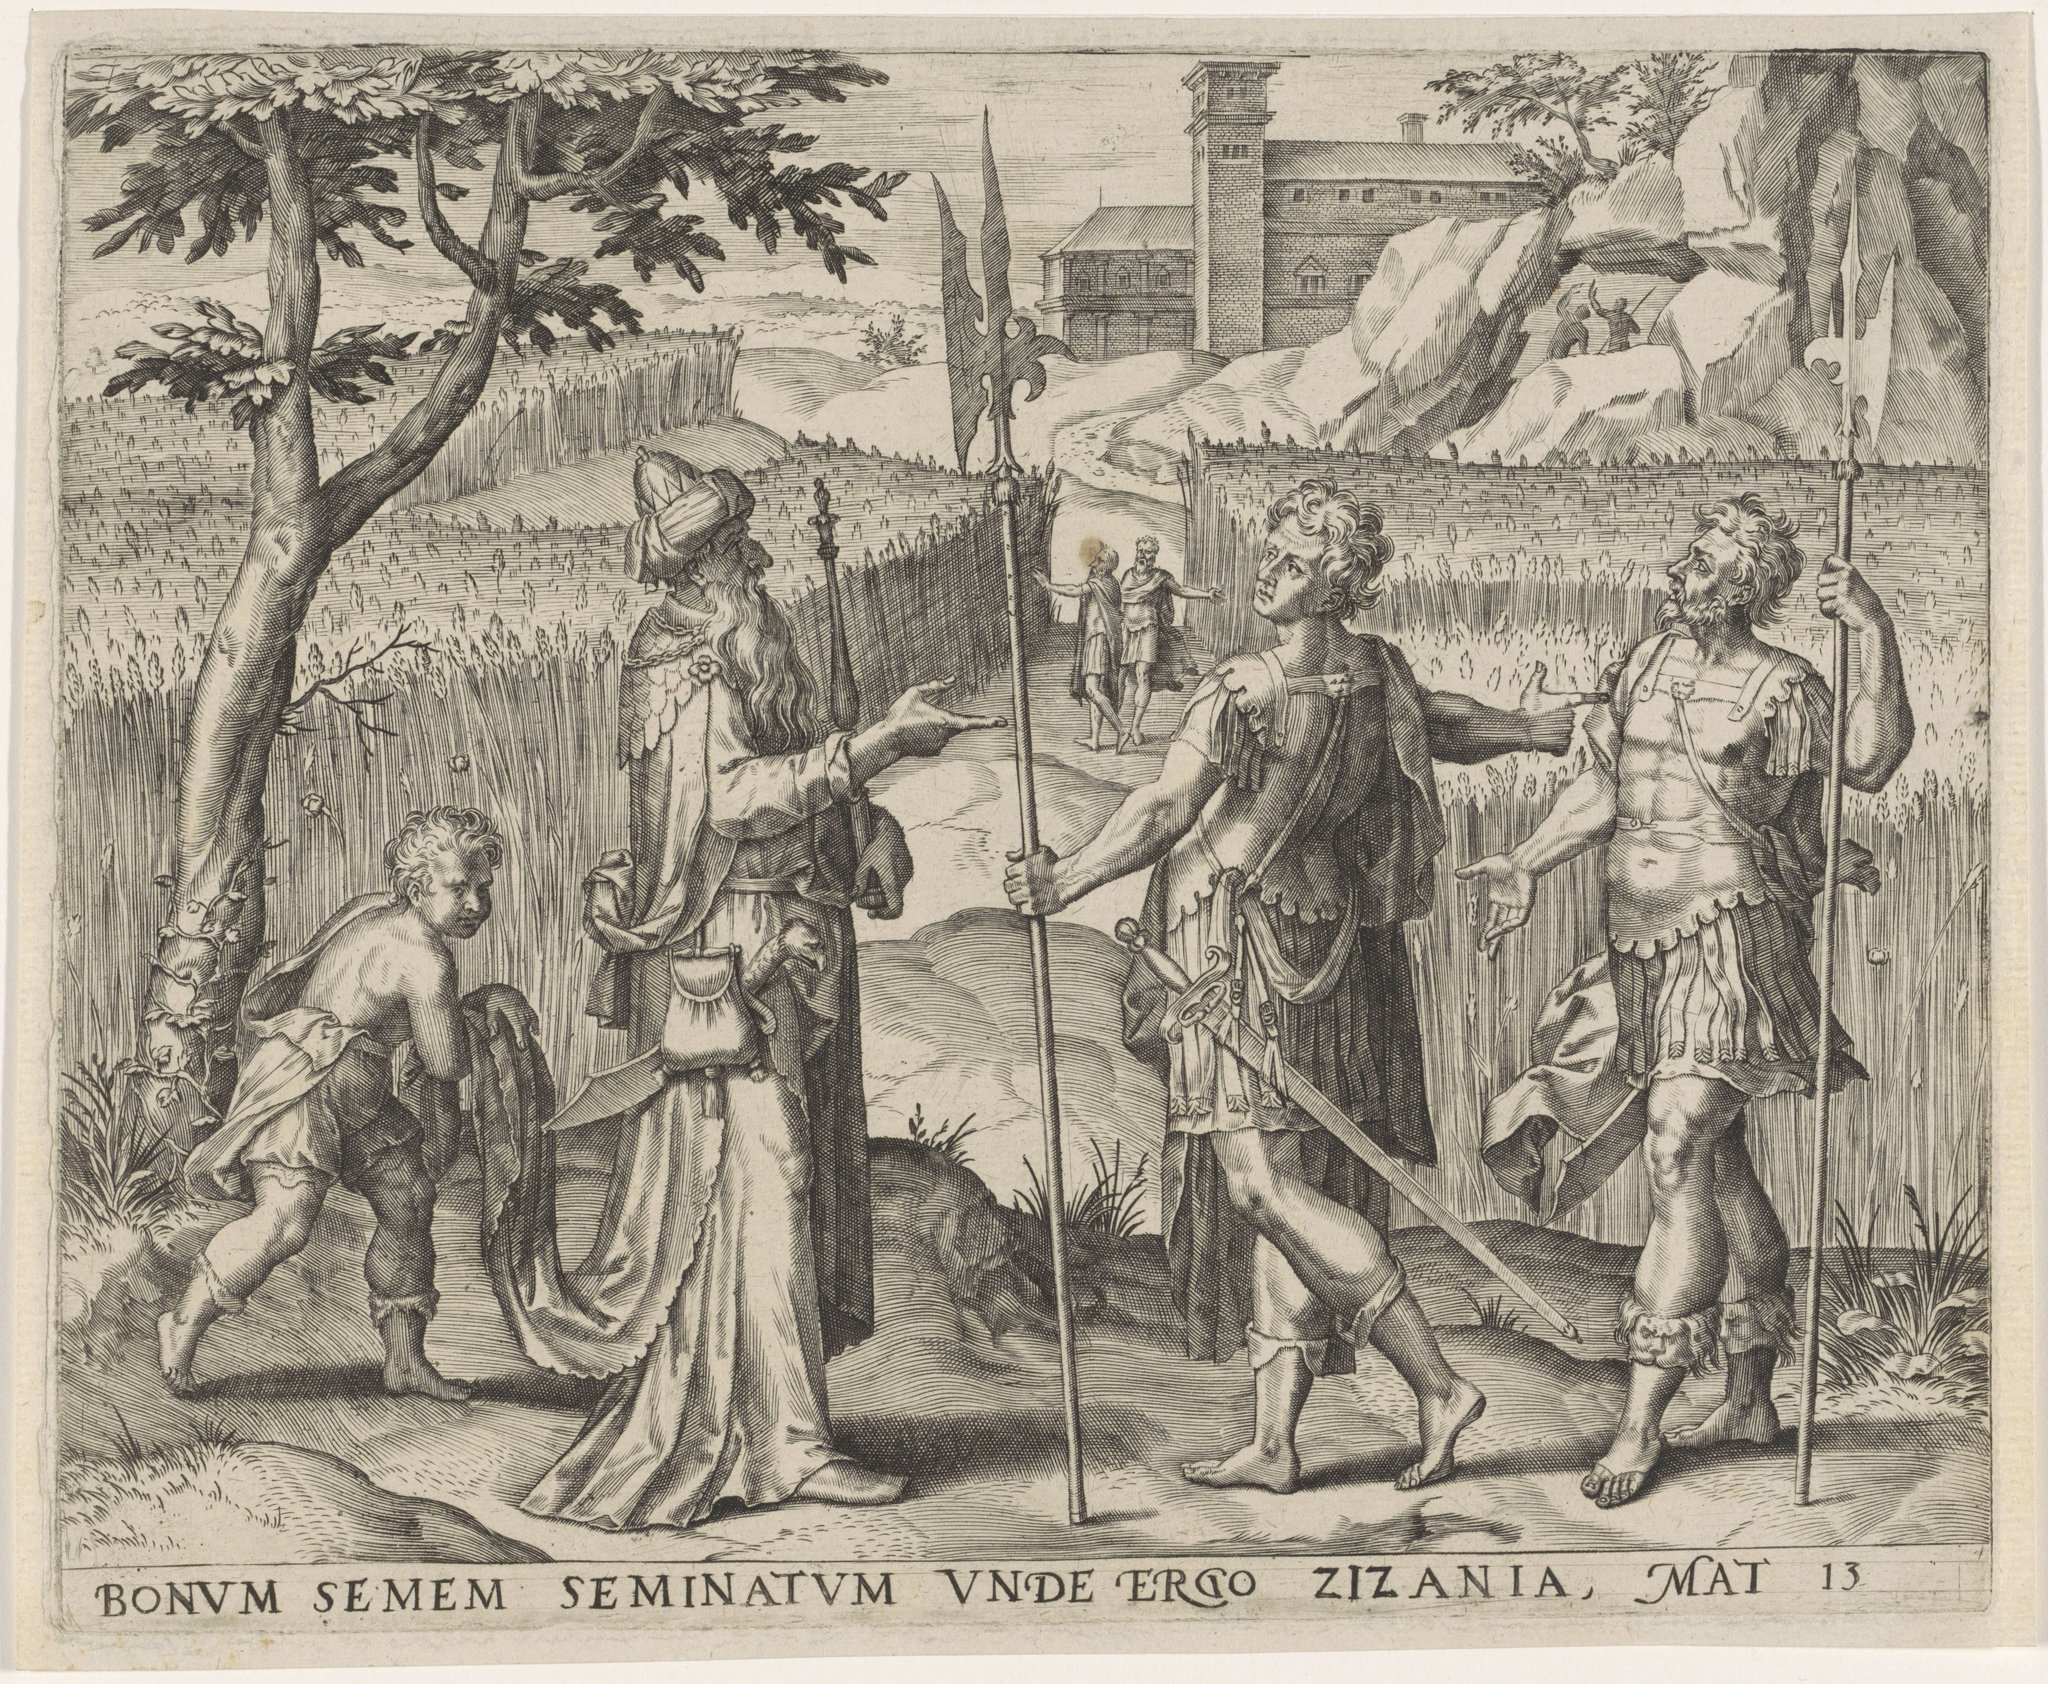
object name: print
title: De landheer inspecteert de velden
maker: Anonymous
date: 1585-1700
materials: paper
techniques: engraving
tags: a sower sowed good seeds in his field ~ tares among the wheat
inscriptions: collector's mark: Lugt 2233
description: De knechten, beiden met een hellebaard in de hand, vragen aan de landheer of zij het onkruid tussen het graan moeten wieden. De landheer geeft als antwoord dat het graan en het onkruid moeten blijven groeien tot aan de oogst. Een jongen houdt het kleed van de landheer vast. Onder de voorstelling een verwijzing in het Latijn naar de Bijbeltekst in Mat. 13.